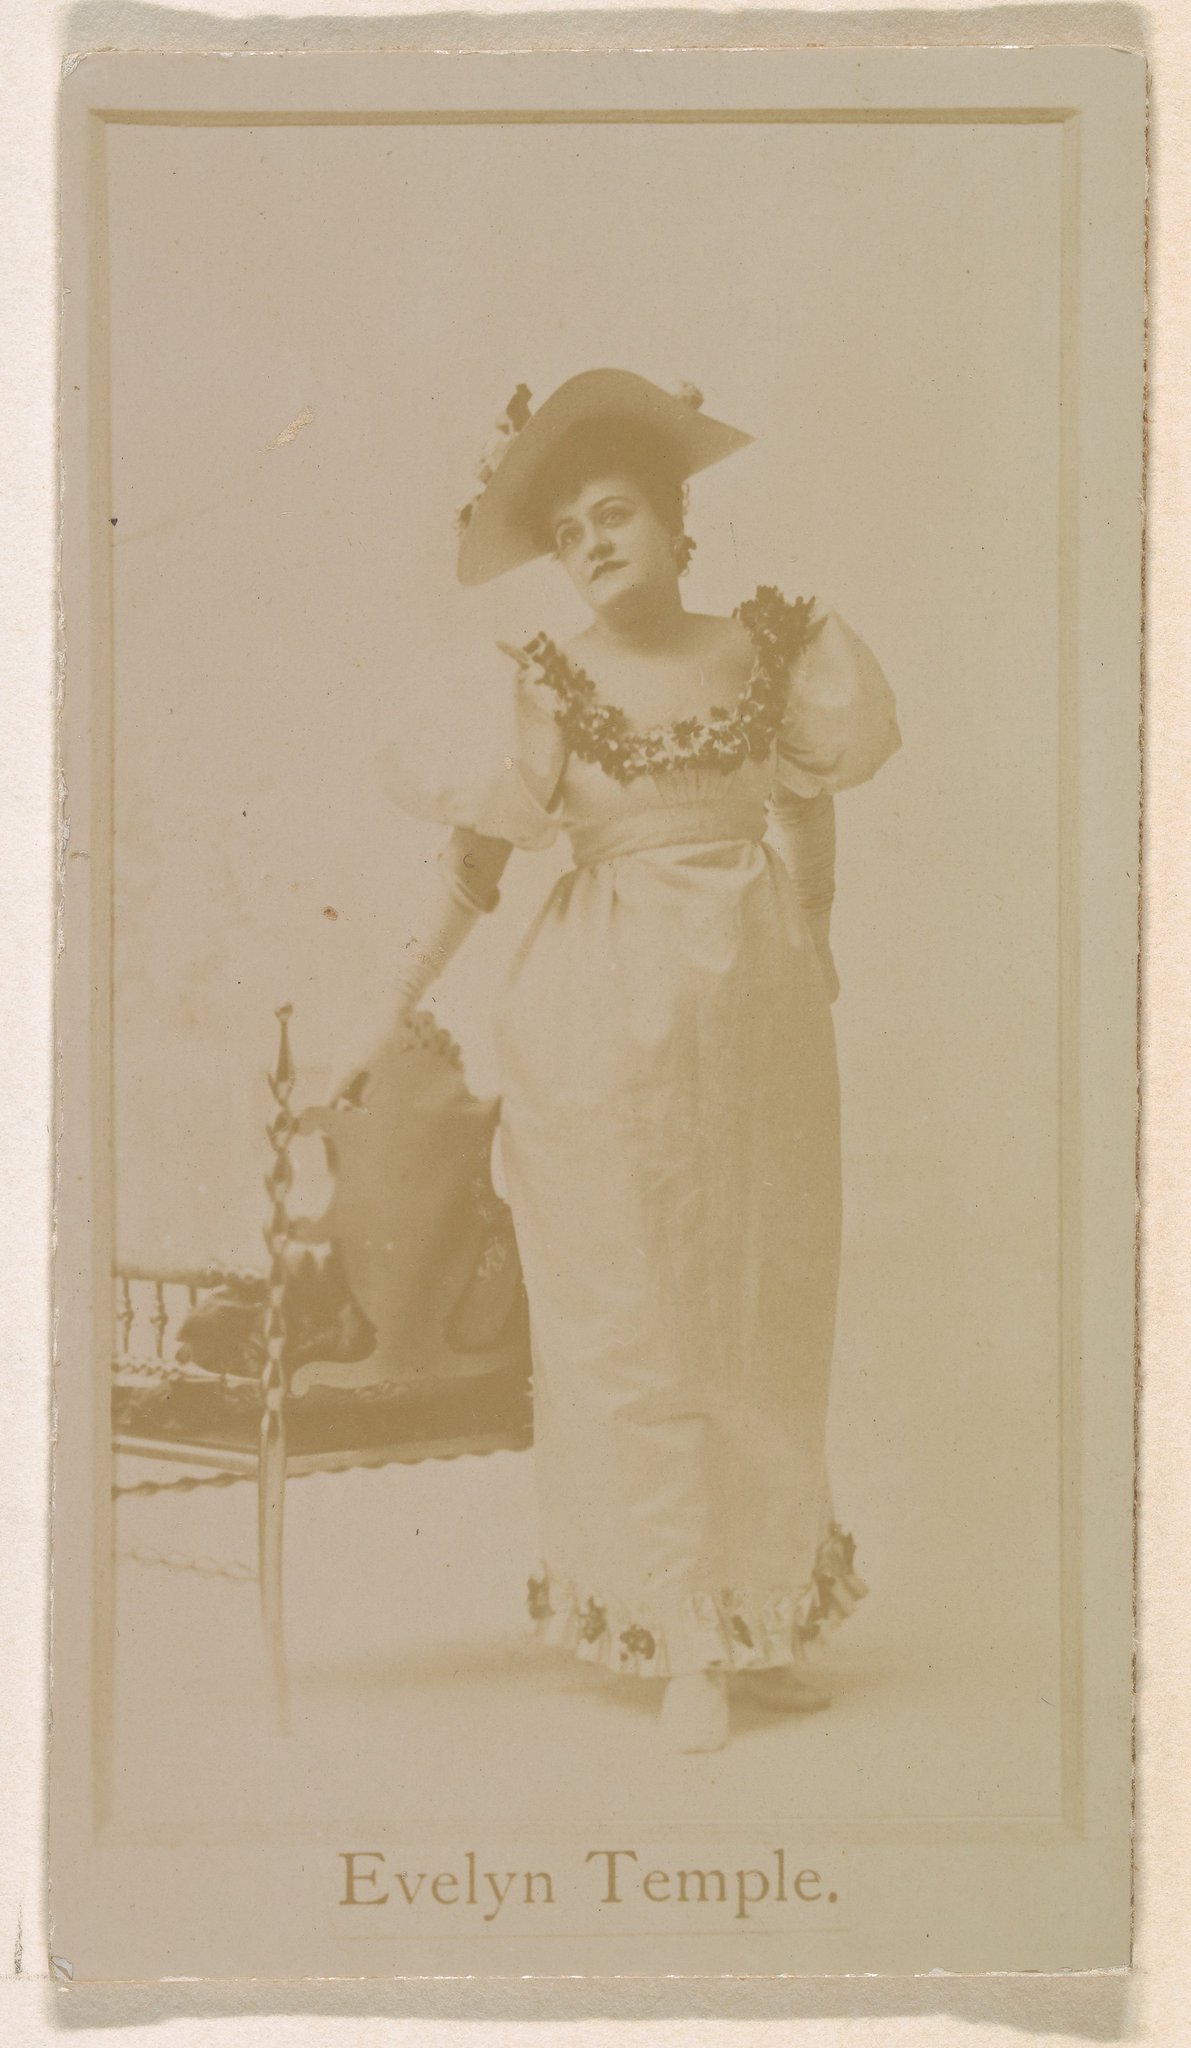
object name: photograph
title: Evelyn Temple, from the Actresses series (N245) issued by Kinney Brothers to promote Sweet Caporal Cigarettes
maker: kinney brothers tobacco company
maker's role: publisher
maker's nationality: american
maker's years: 1869-2011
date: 1890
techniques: albumen silver print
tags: portraits,women,actresses